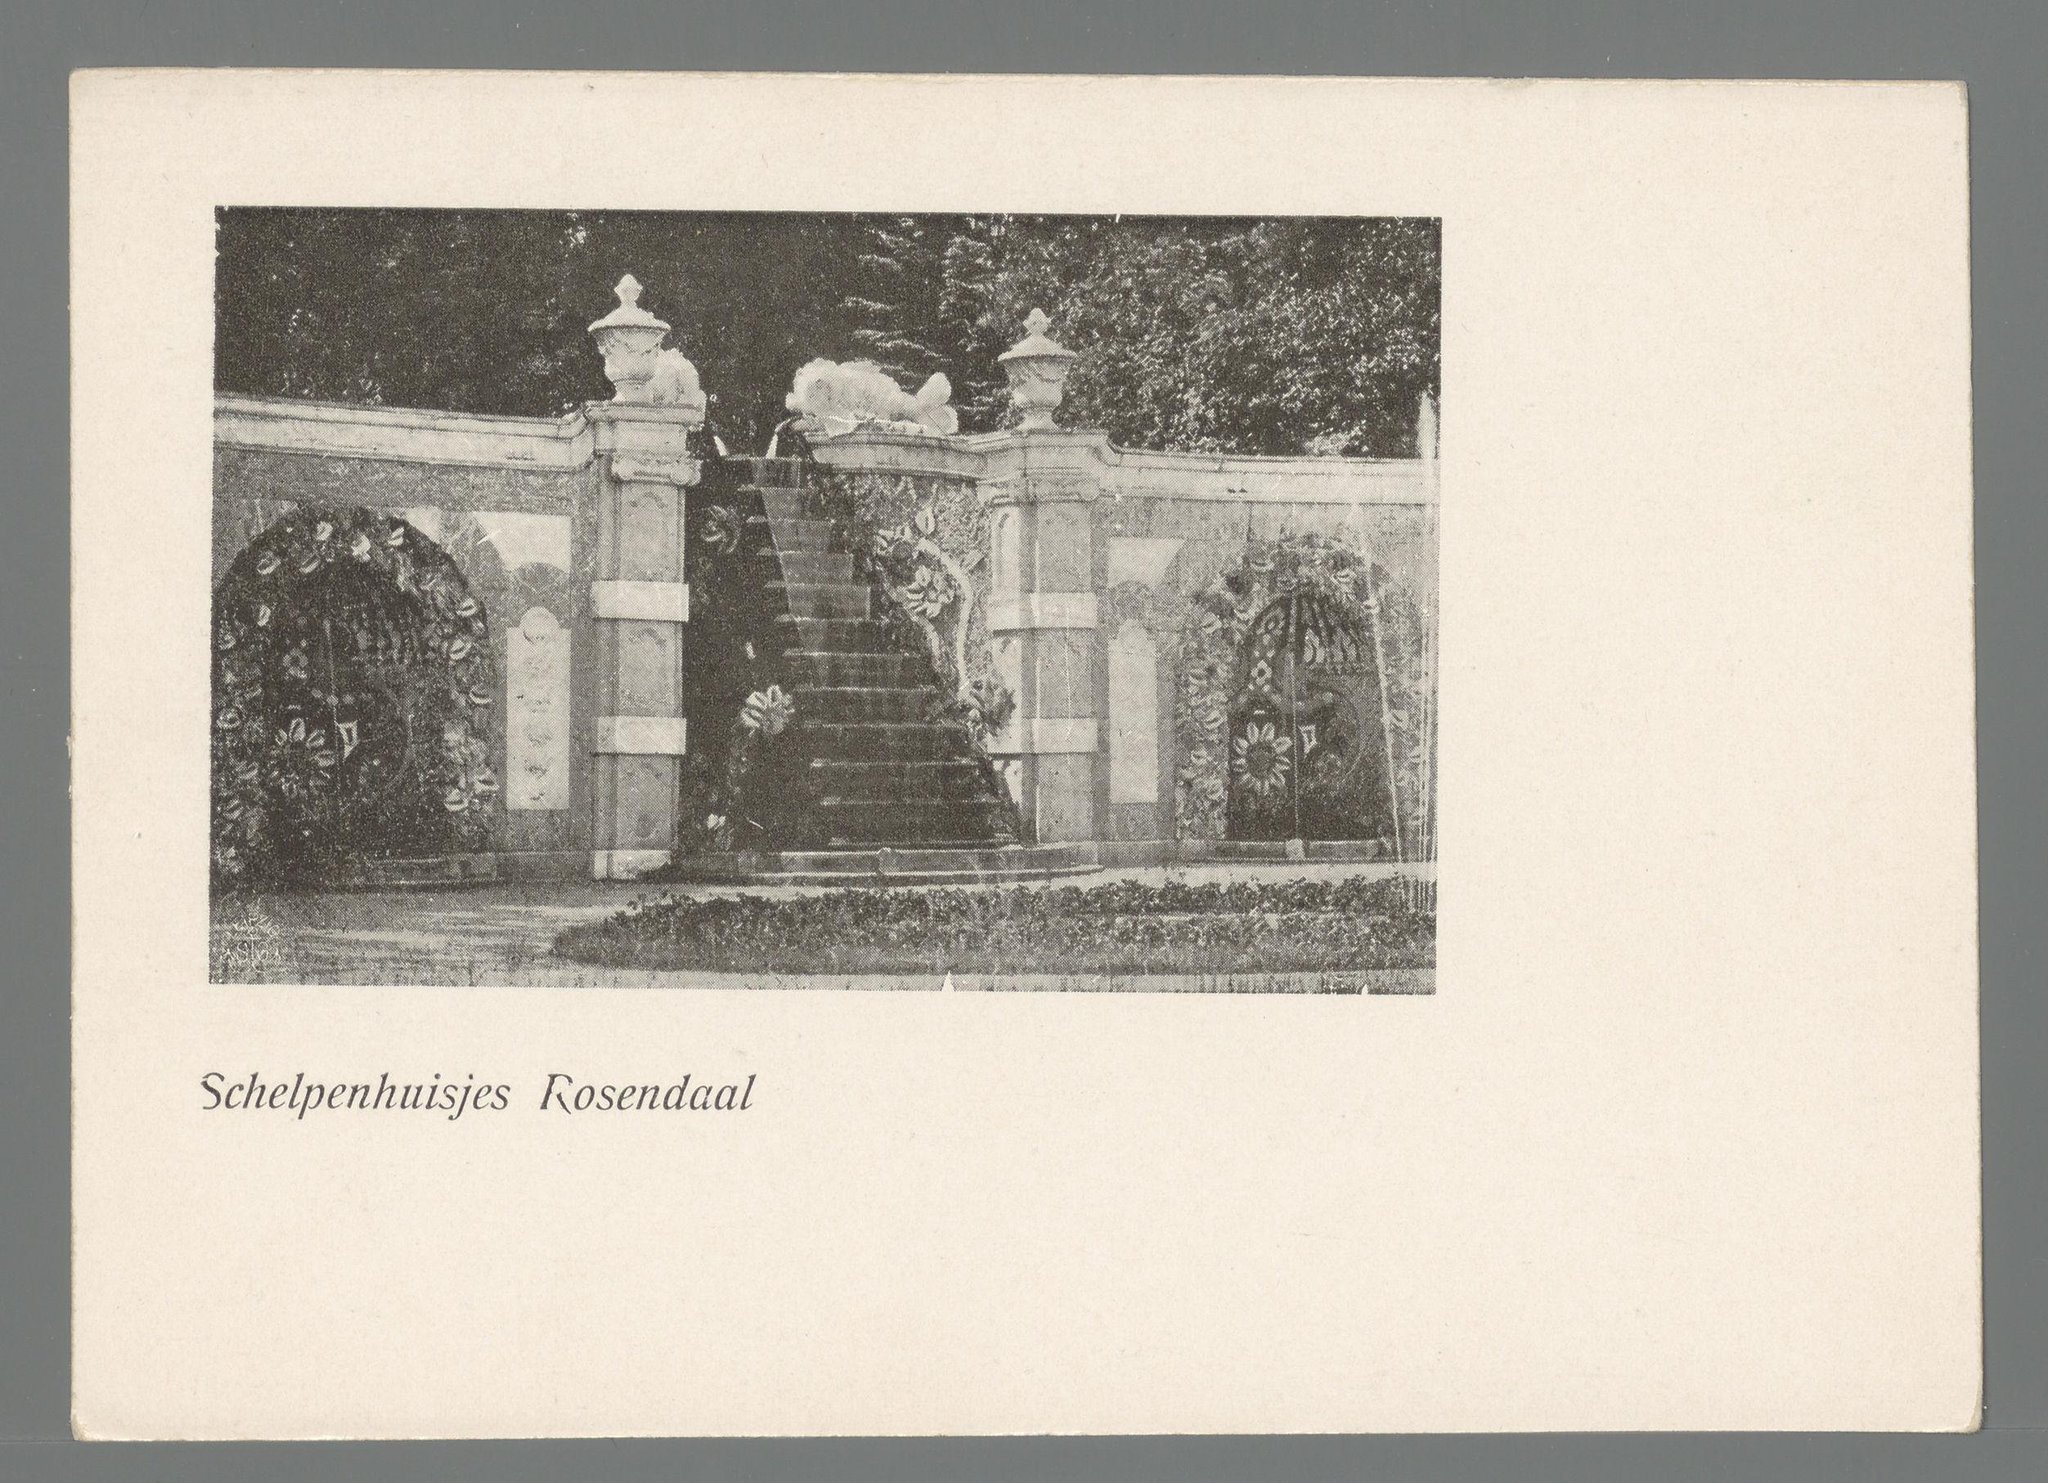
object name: photomechanical print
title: Schelpenhuisjes Rosendaal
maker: Anonymous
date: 1892-1905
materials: cardboard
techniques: autotype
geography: rozendaal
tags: scallop, shell ~ ornament